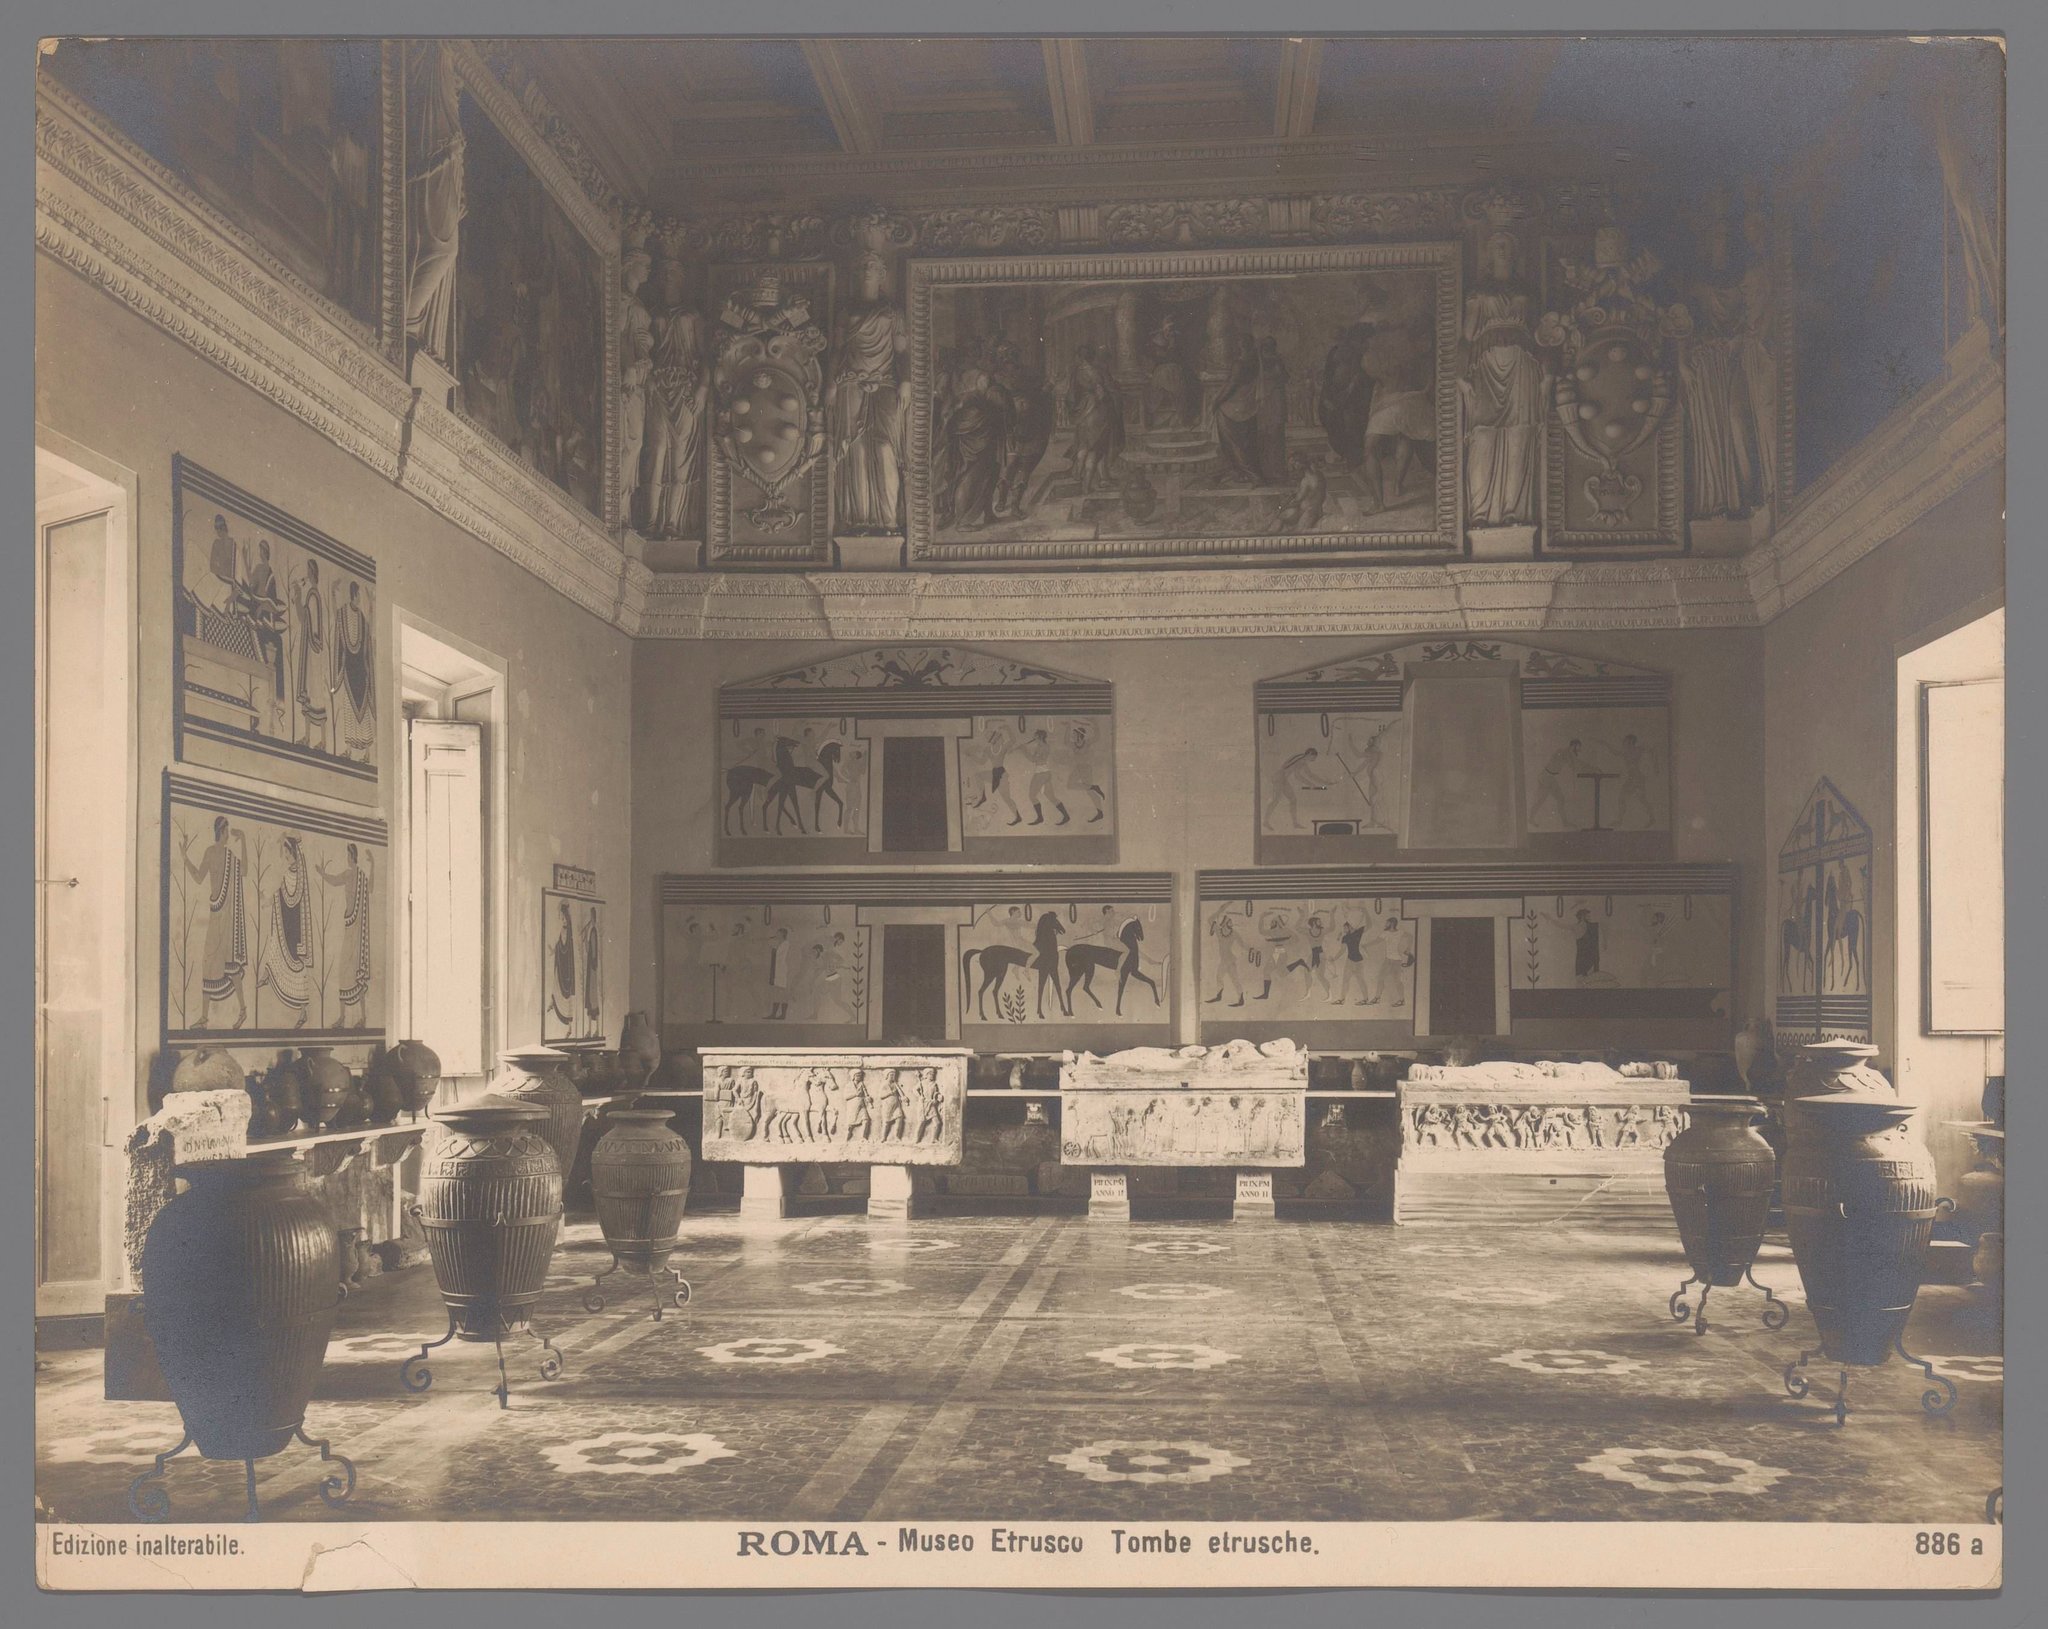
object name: photograph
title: Opstelling van Etruskische graftombes in het Museo nazionale etrusco di Villa Giulia te Rome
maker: Anonymous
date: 1889-1910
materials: photographic support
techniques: gelatin silver print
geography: museo nazionale etrusco di villa giulia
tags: castle, grave, tomb, interior ~ representation of a building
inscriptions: collector's mark: Lugt 3937, number: ‘886 a’